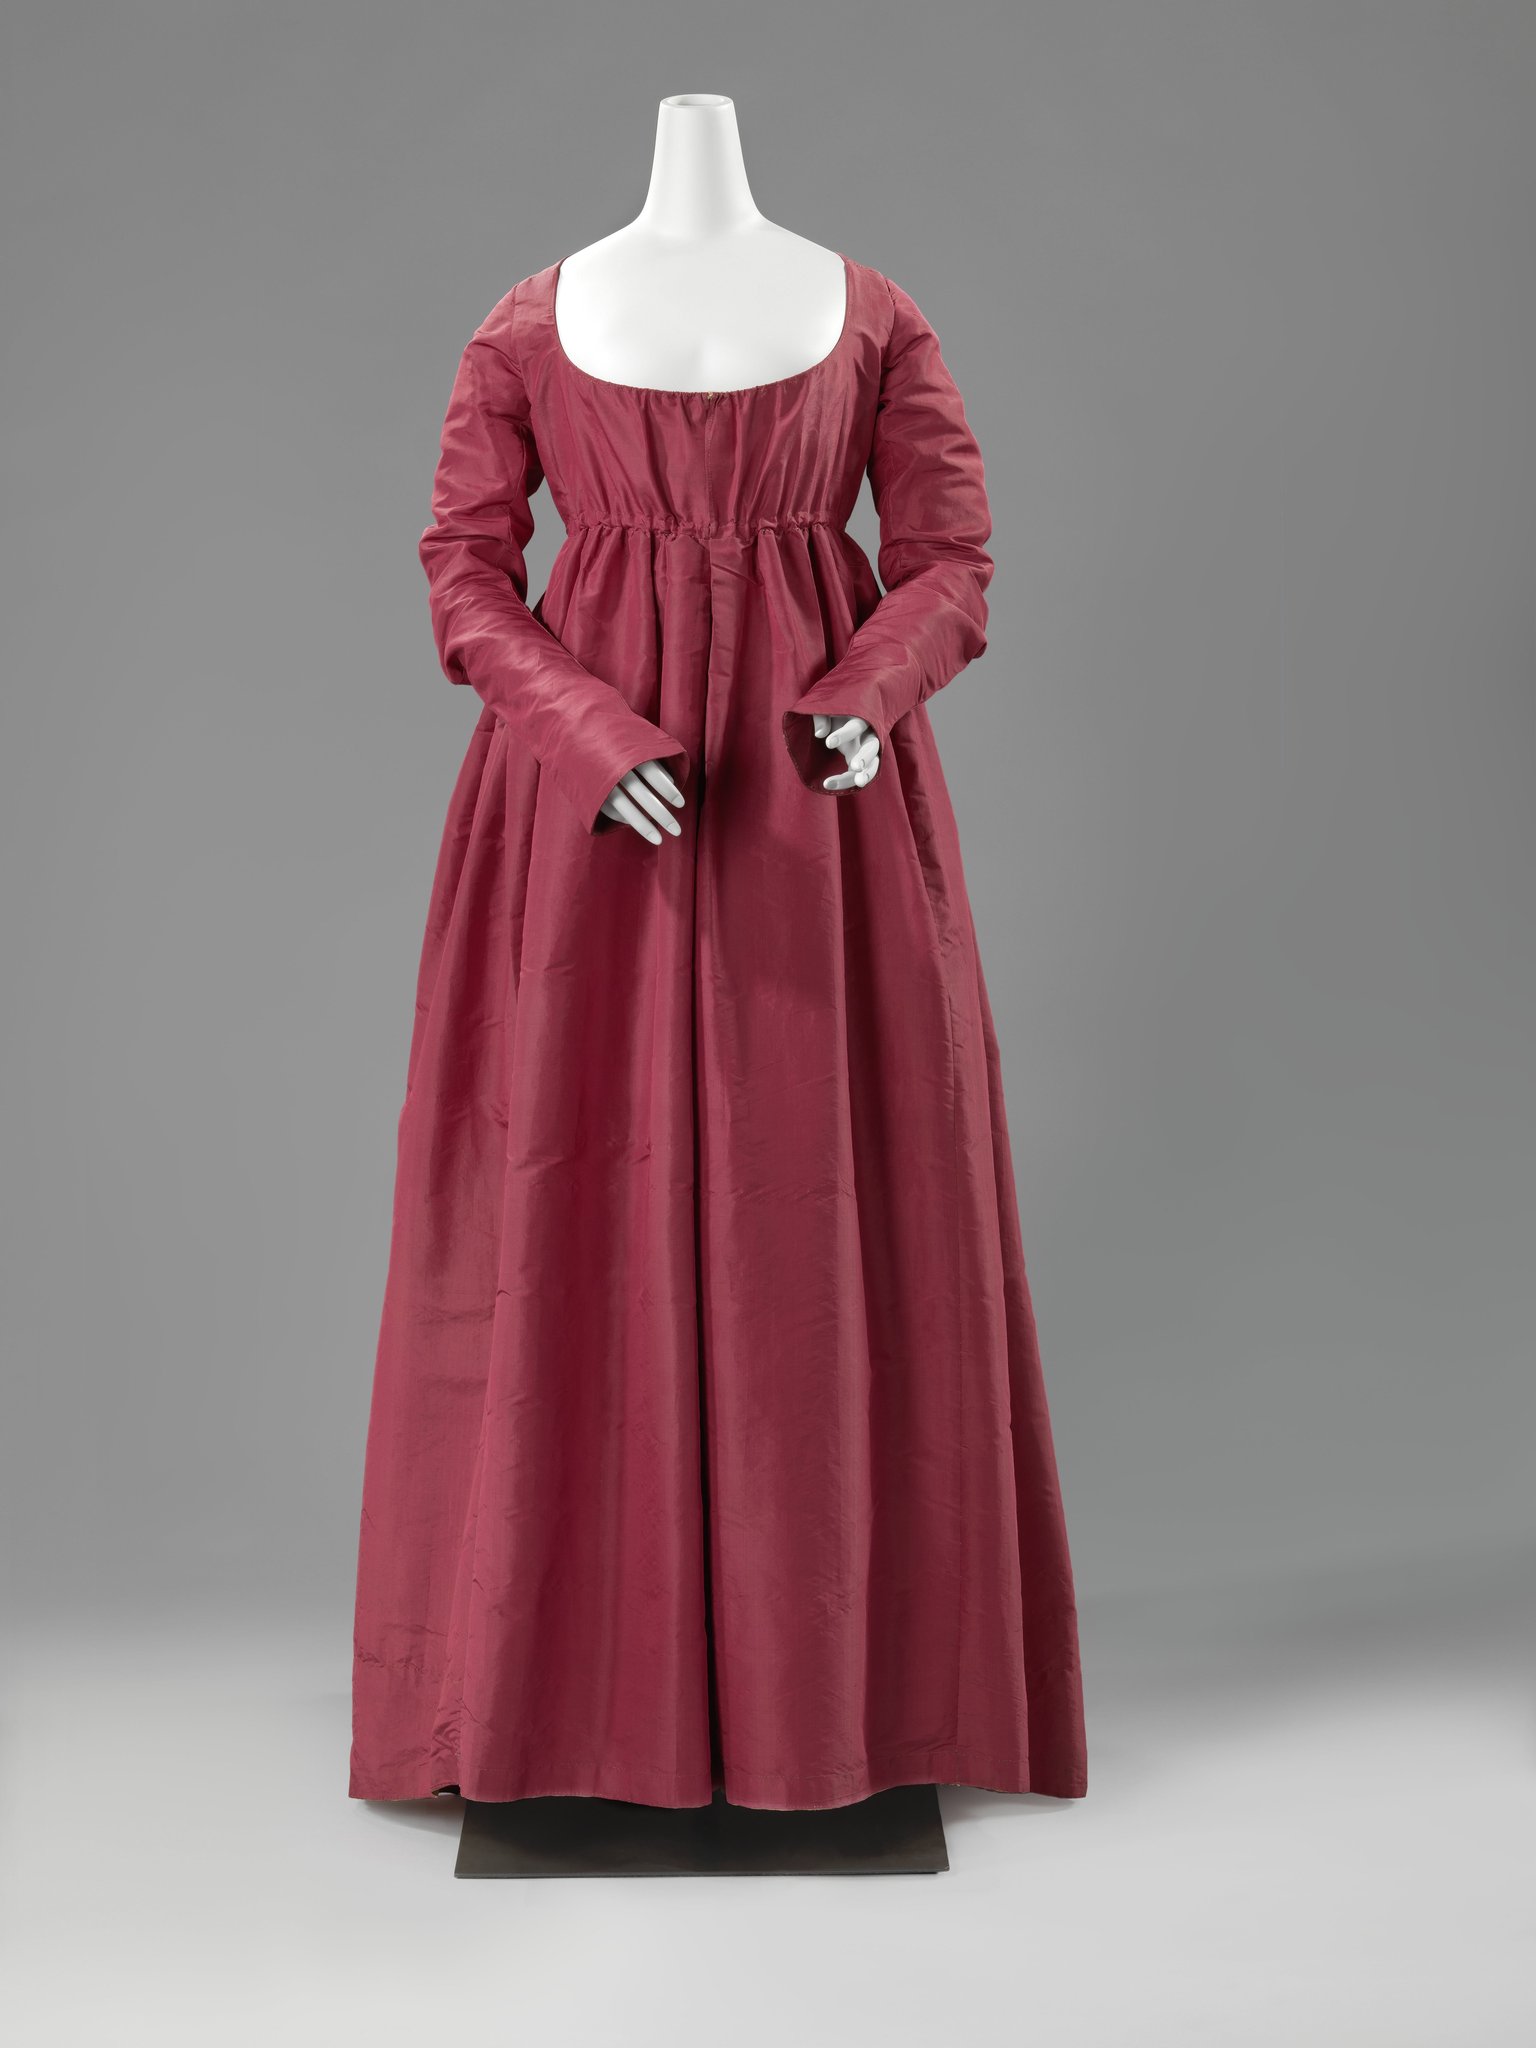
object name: womenswear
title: Gown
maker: Anonymous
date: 1790-1810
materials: cotton, linen, metal, silk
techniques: weave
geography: netherlands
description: At the end of the 18th century the wide skirts became narrower, and the waistline was raised to under the bosom. The narrow sleeves were so long that they extended to the middle of the hand. They were set in far at the back to a typical lozenge-shaped panel, the shape of which is emphasized by ornamental stitching in a colour that contrasts with the red silk of the dress.